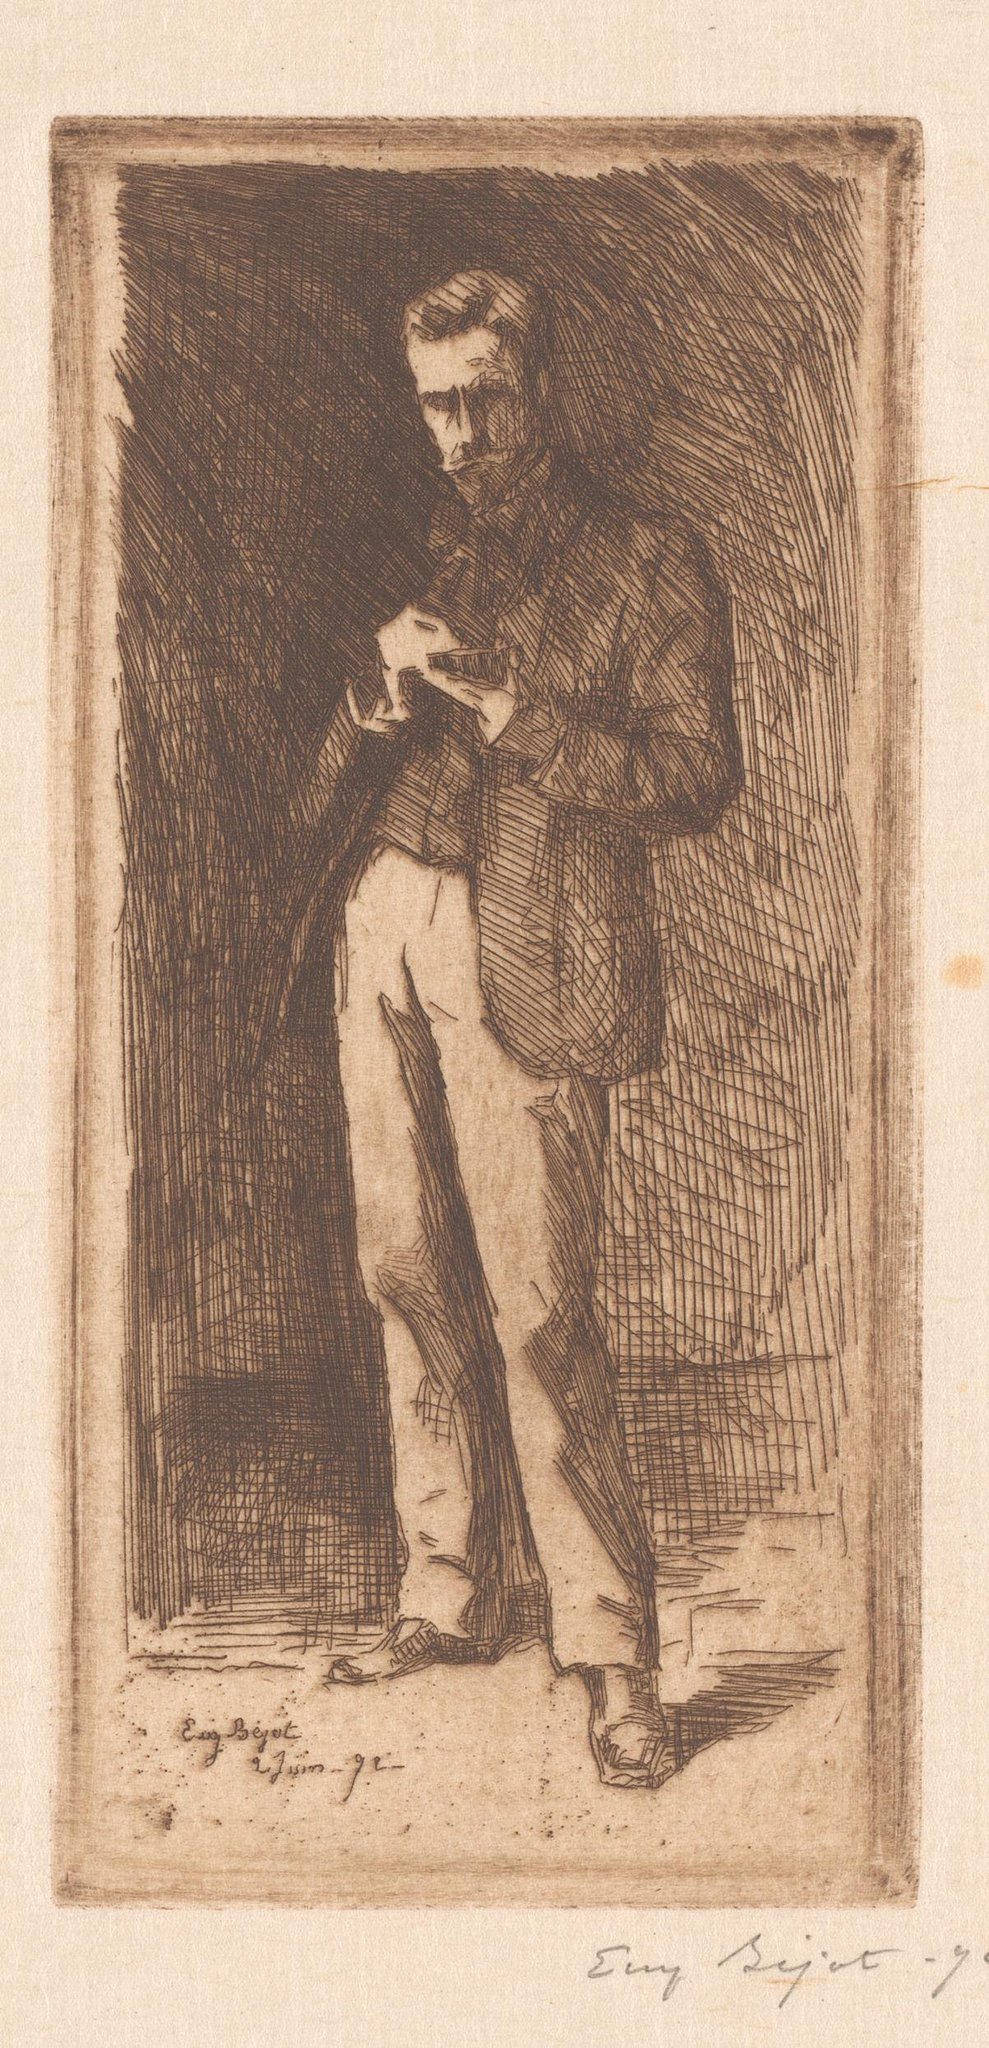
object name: print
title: Zelfportret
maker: eugène bejot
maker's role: print maker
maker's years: 1867-1931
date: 1892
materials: paper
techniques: etching, intaglio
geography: france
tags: drawing, portrait, self-portrait of graphic artist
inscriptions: collector's mark: Lugt 2760, collector's mark: Lugt 2228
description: De kunstenaar heeft zichzelf staand en al tekenend geportretteerd.